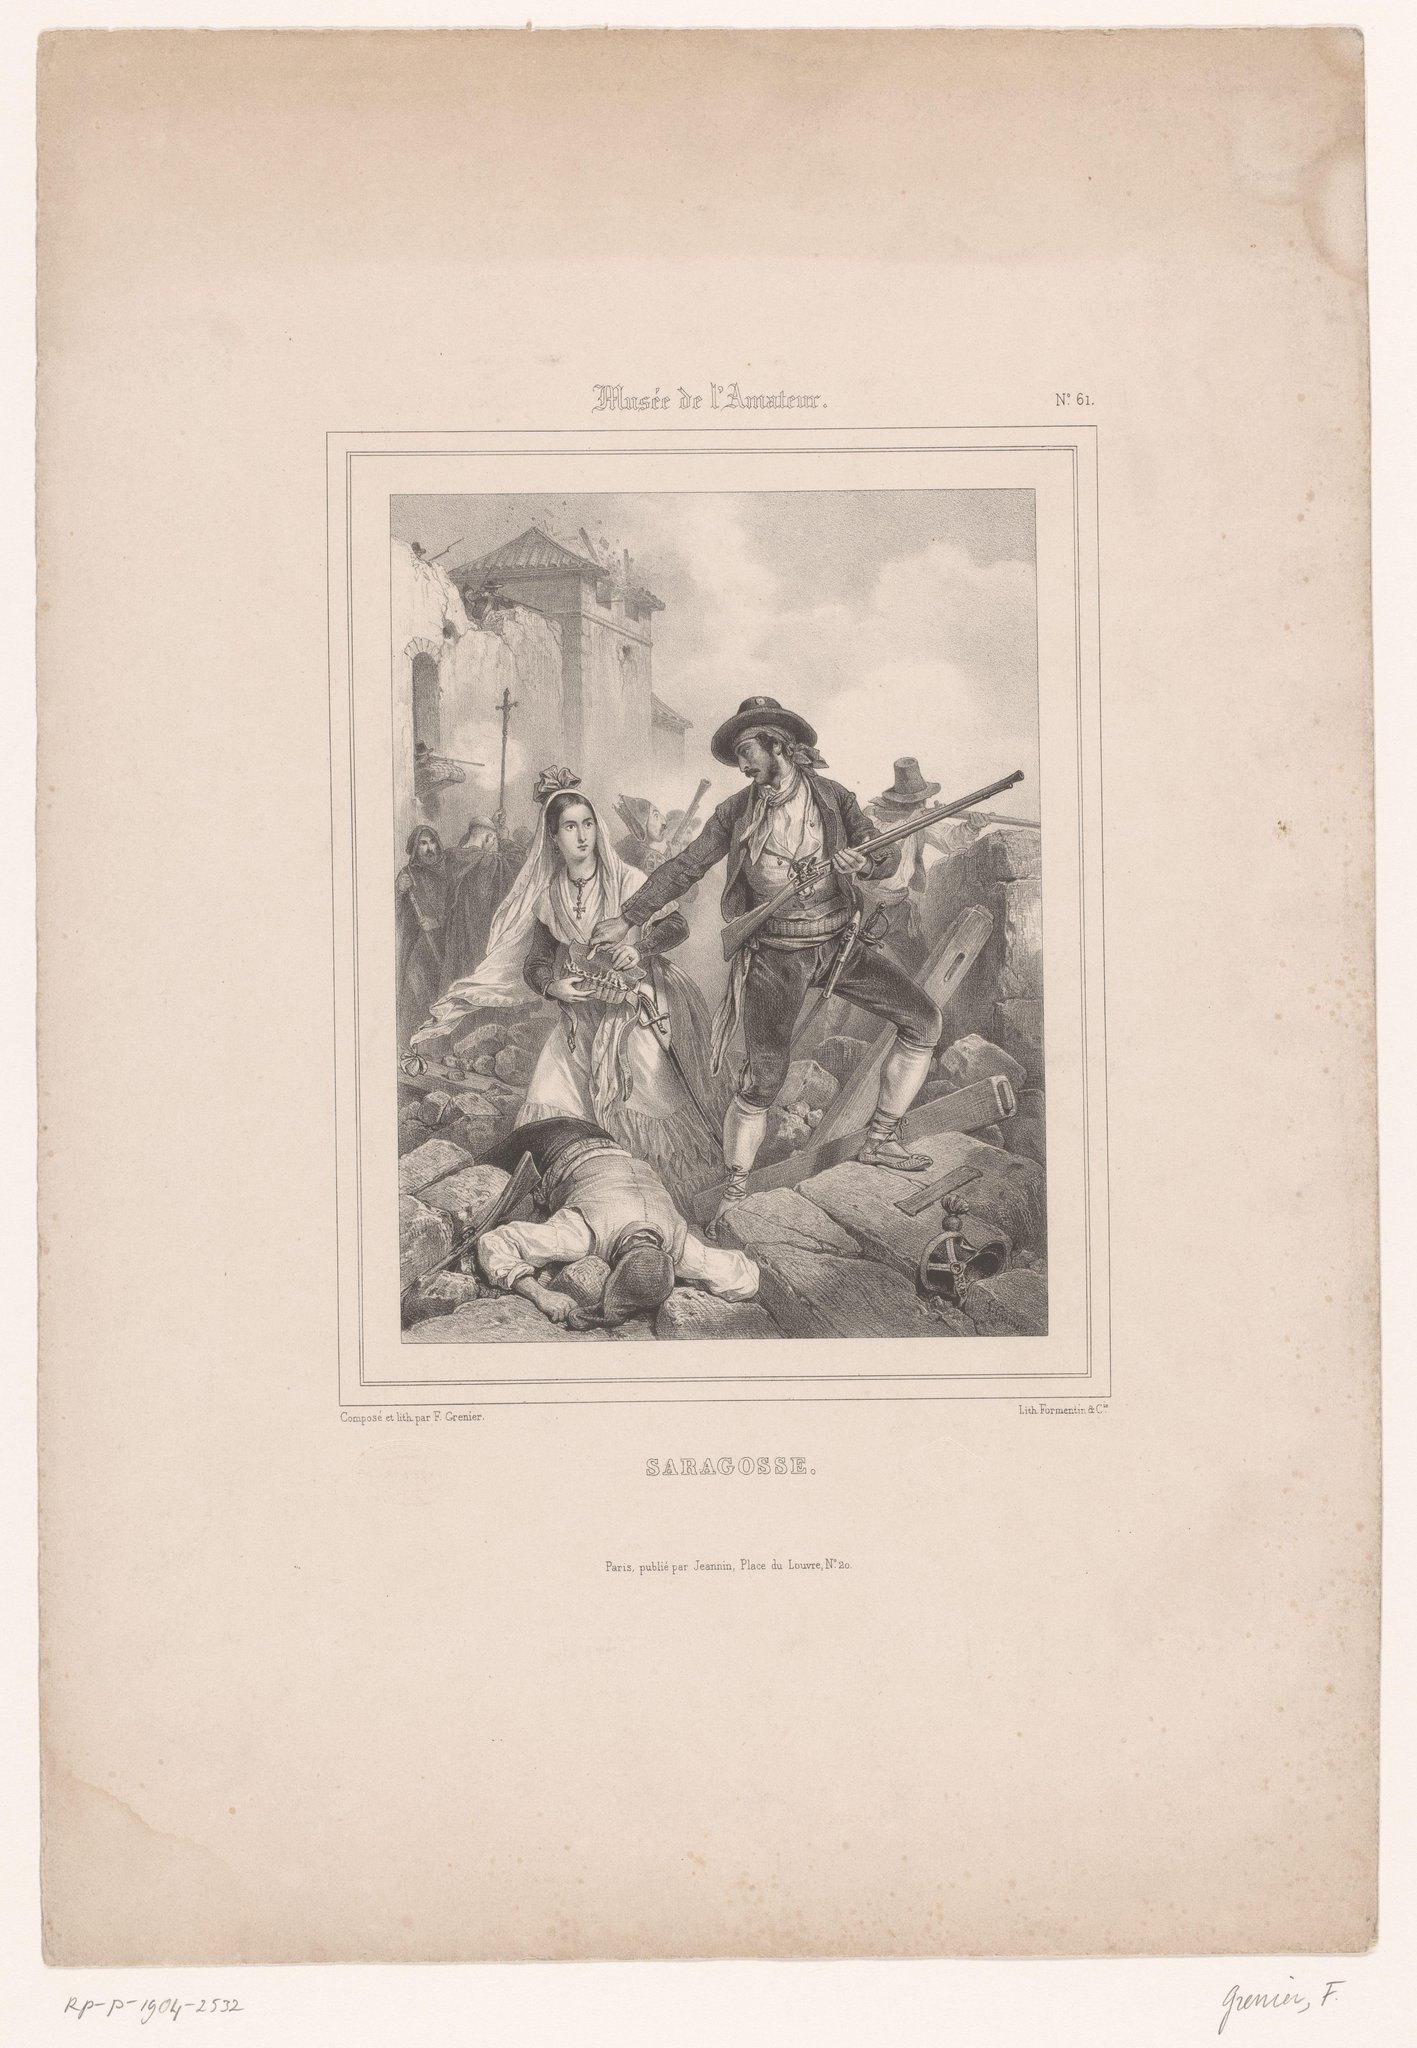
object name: print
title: Museum voor de kunstliefhebber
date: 1838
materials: paper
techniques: lithograph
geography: paris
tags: firearms: rifle, siege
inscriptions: check stamp: Lugt 1397c, collector's mark: Lugt 2228a, check stamp: Lugt 5002